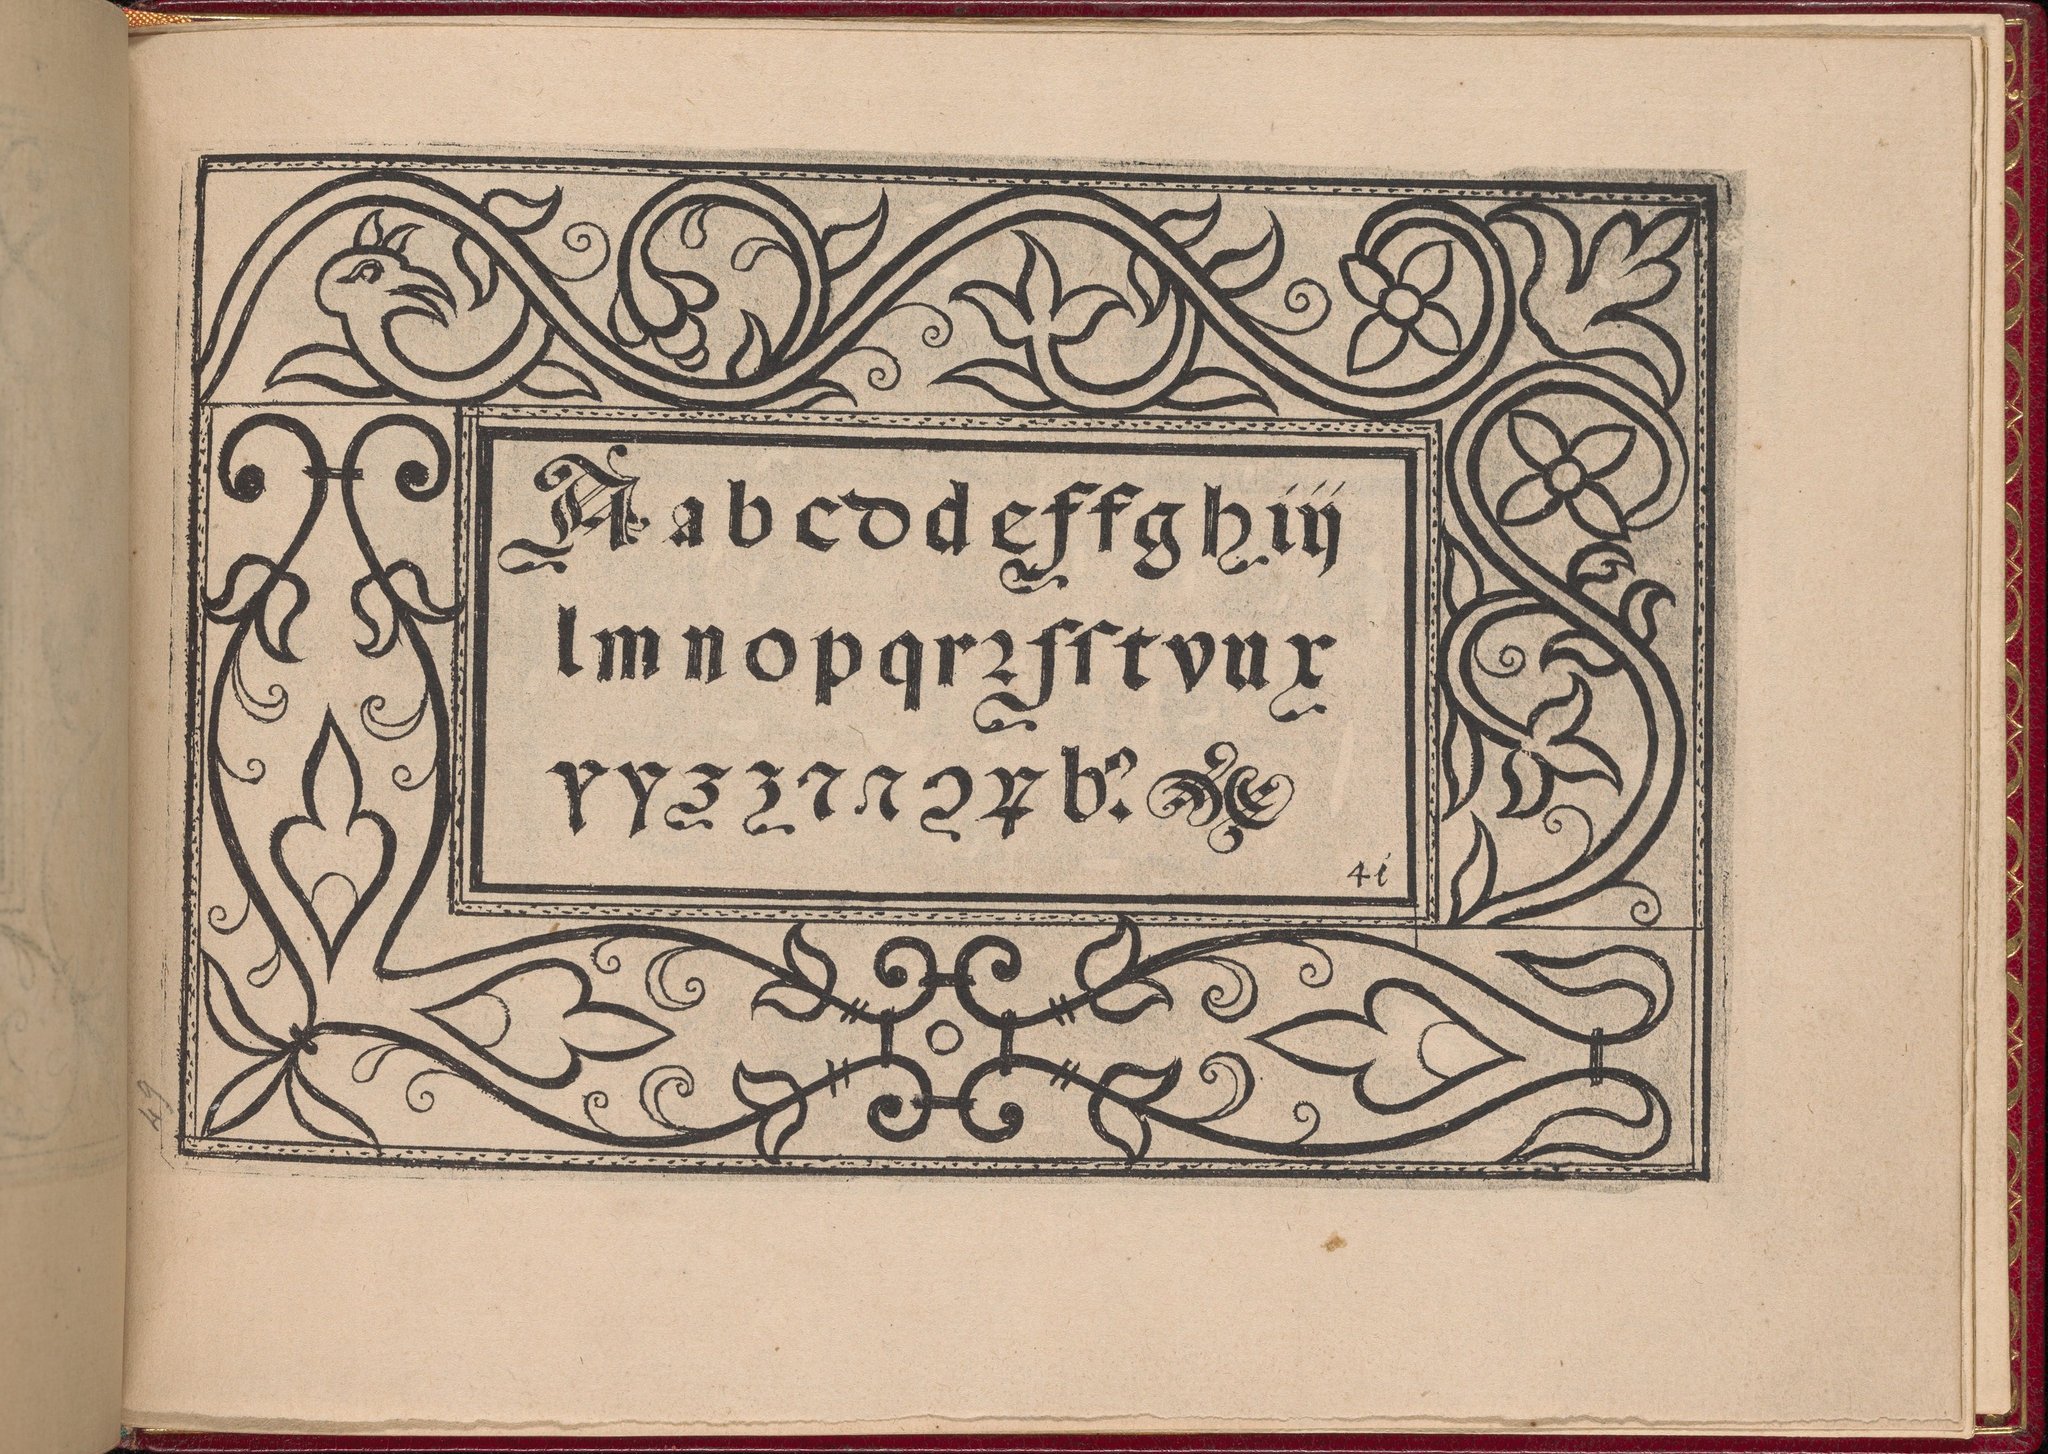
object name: book print ornament architecture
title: Ghirlanda: Di sei vaghi fiori scielti da piu famosi Giardini d'Italia, page 49 (recto)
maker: pietro paulo tozzi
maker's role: designer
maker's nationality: italian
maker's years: 1593-1628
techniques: drawing, etching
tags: flowers